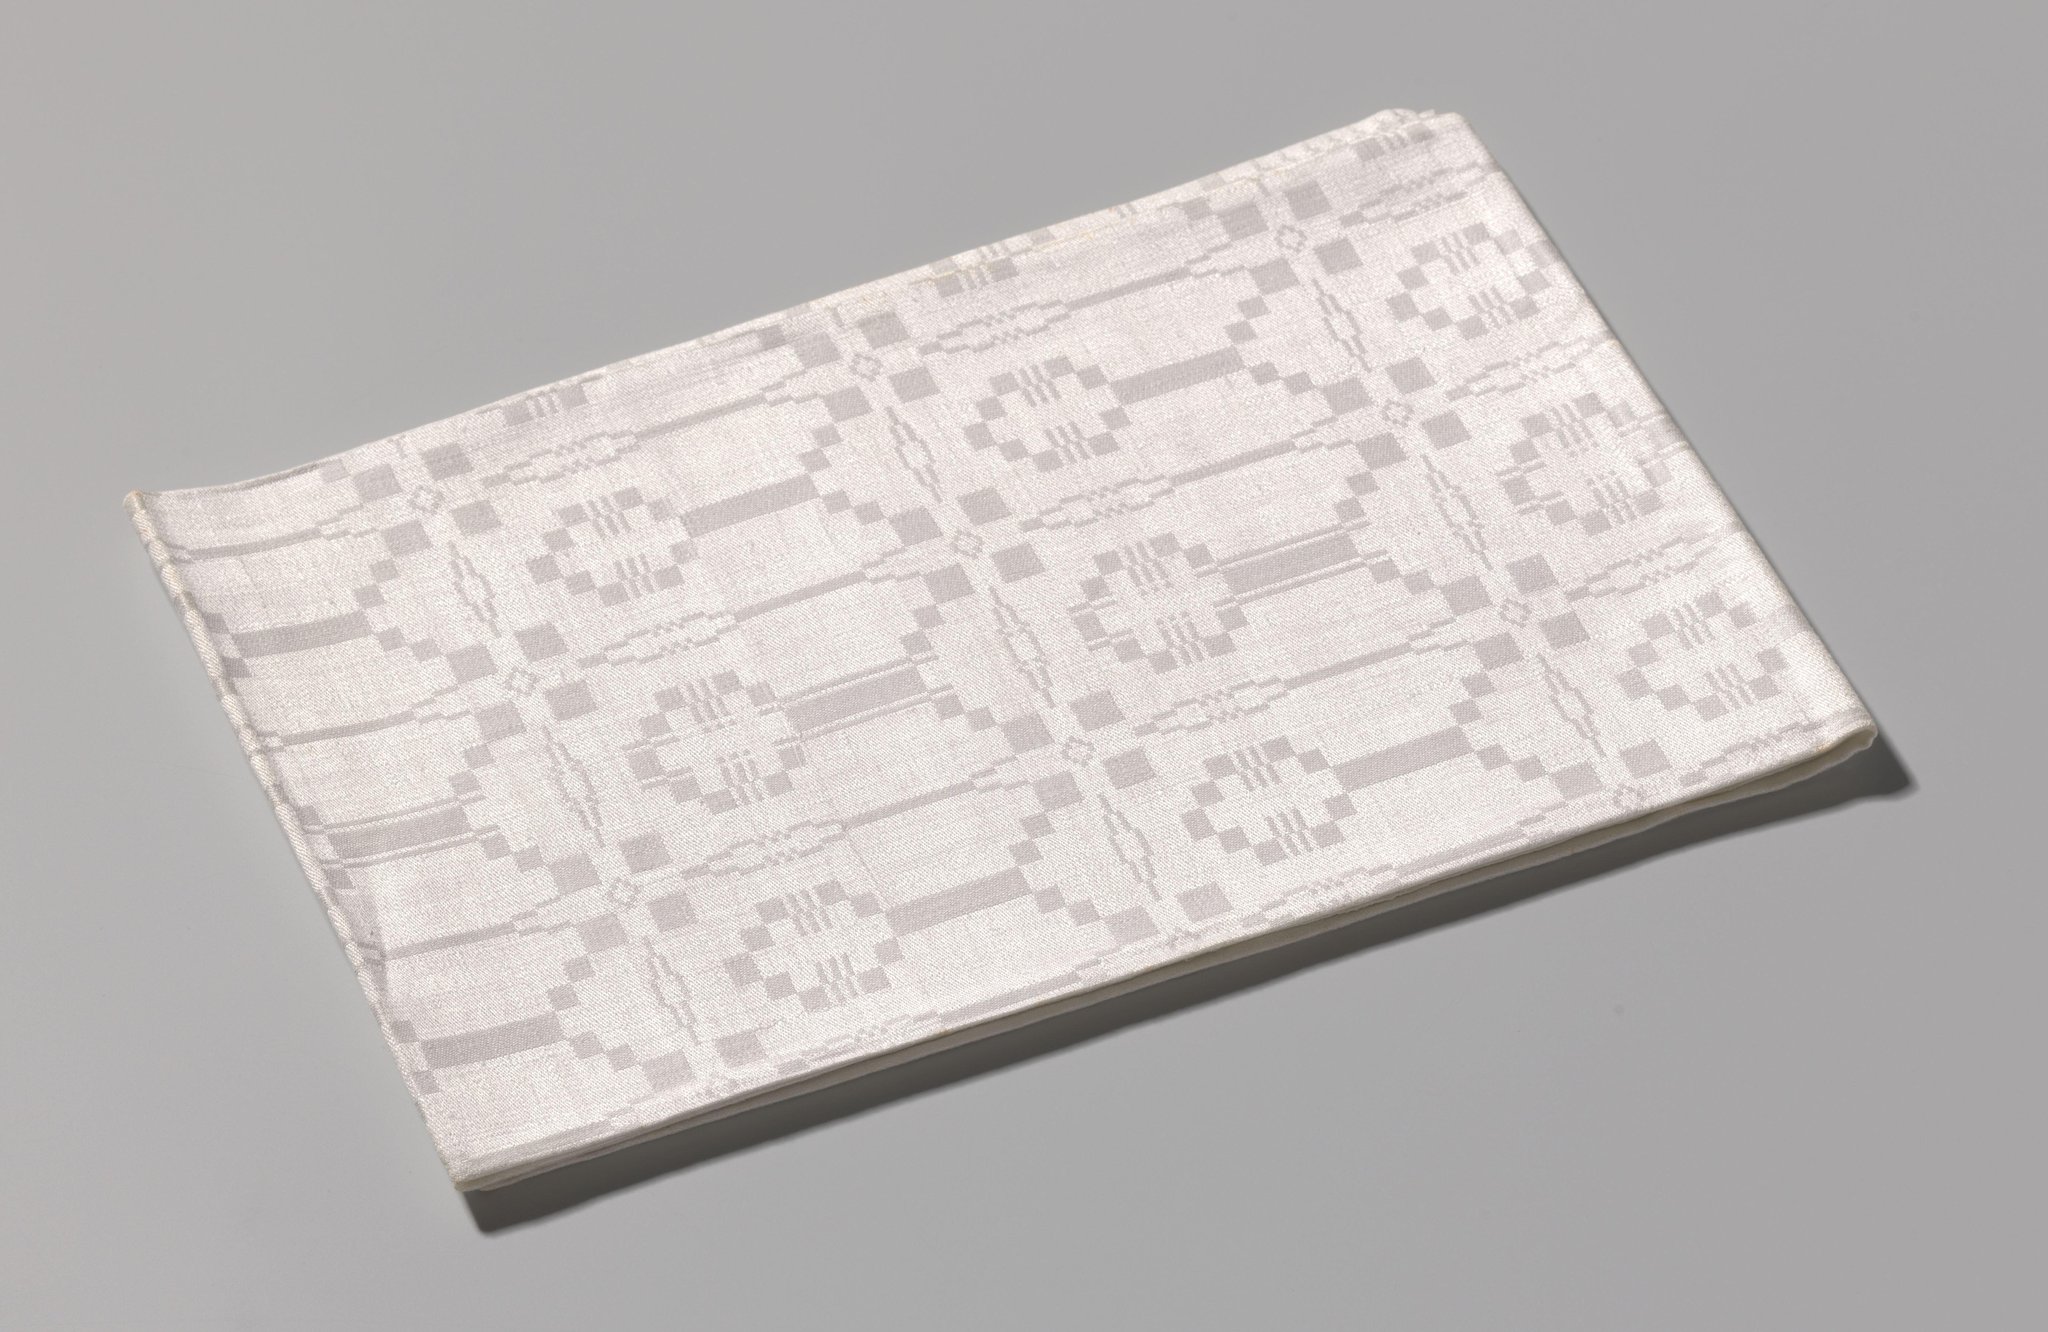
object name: napkin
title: Servet van linnen met pellenpatroon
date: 1726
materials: linen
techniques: peeled fabric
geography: northern netherlands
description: wit linnen servet met pellen patroon, merk GS 60 en 1726